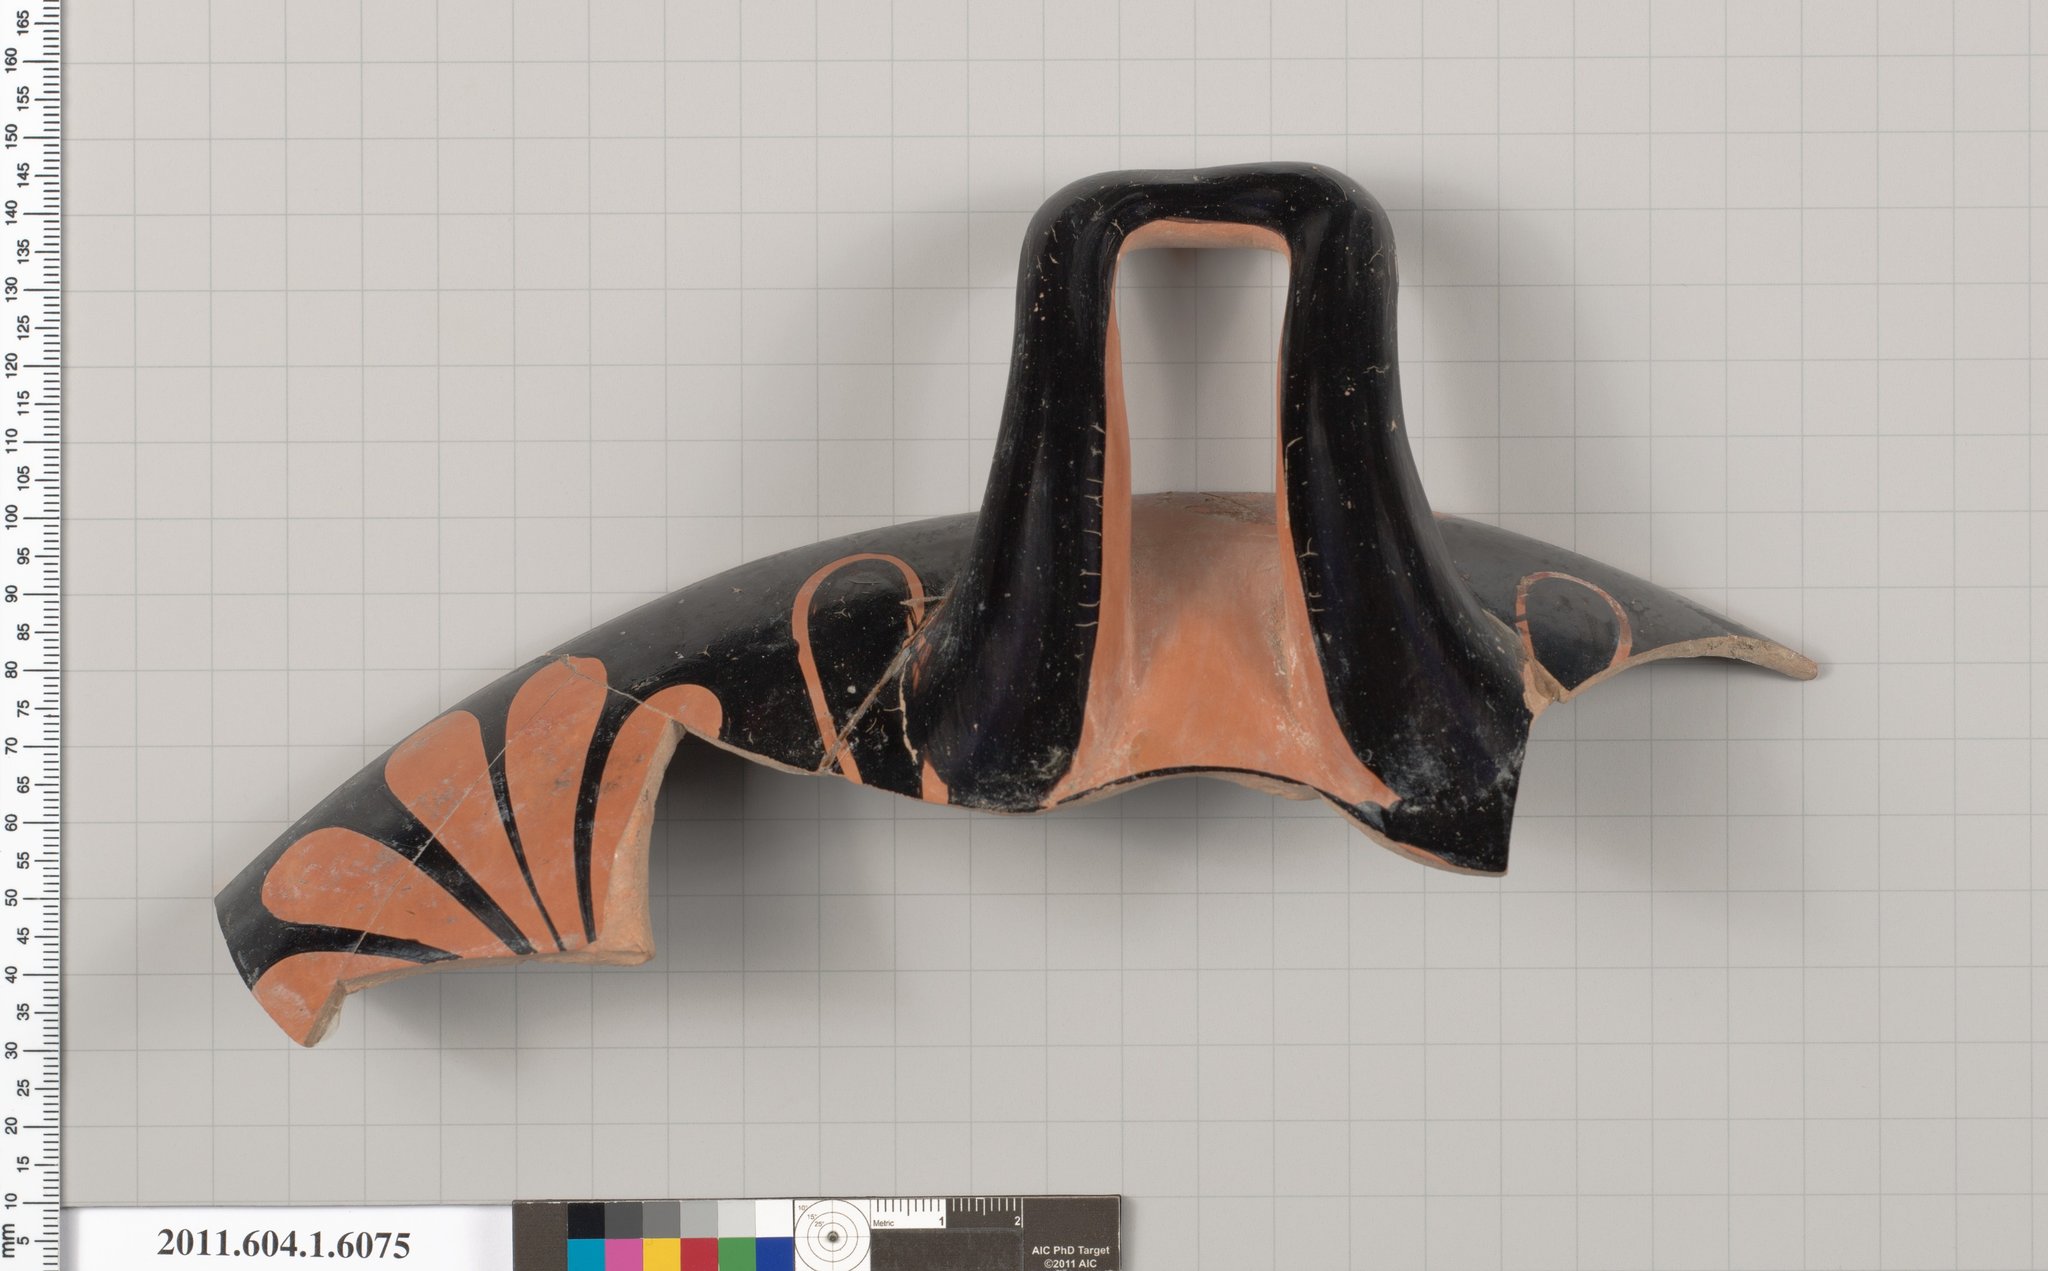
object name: kylix fragment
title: Terracotta fragment of a kylix (drinking cup)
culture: greek, attic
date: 510-500 BCE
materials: terracotta